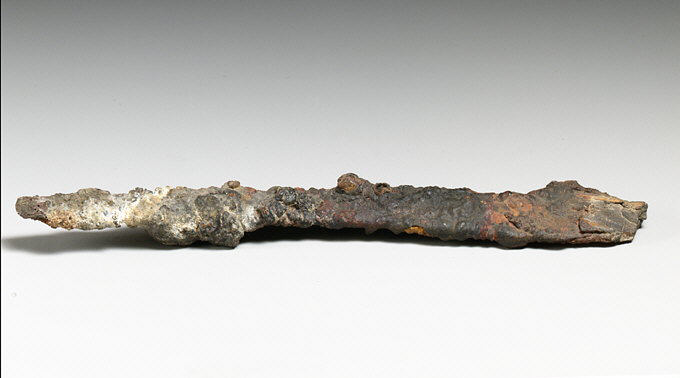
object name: knife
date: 7000 BCE-330 CE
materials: iron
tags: knives